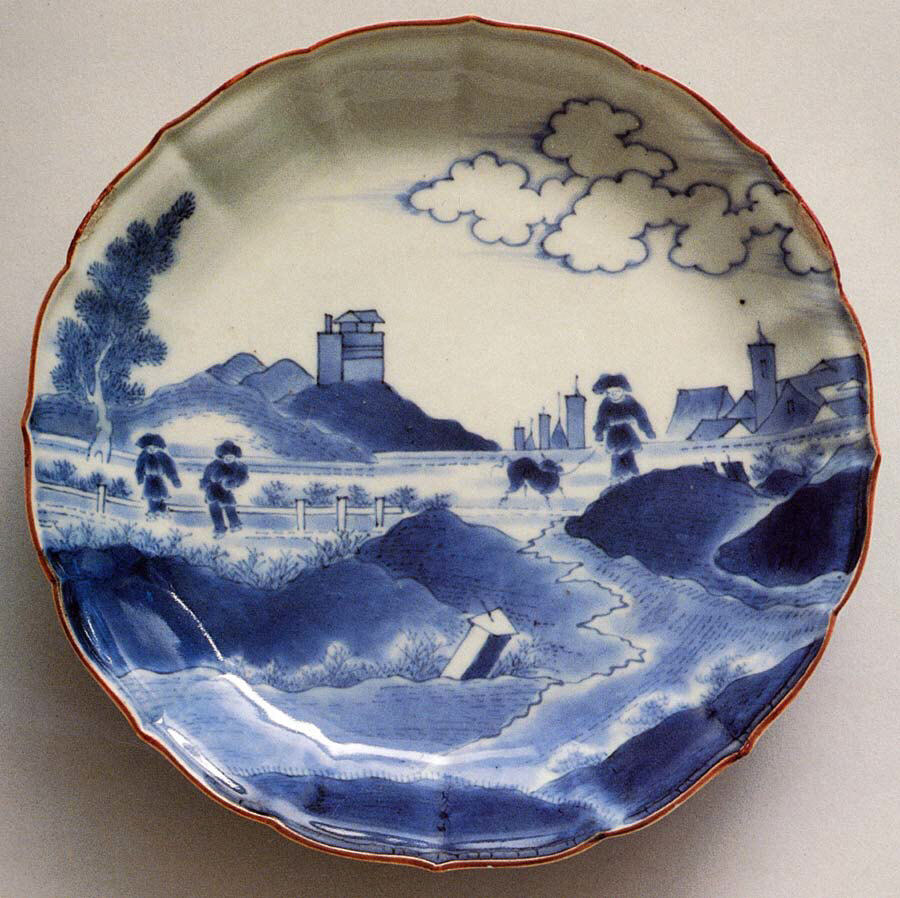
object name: dish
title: Dish with Dutch Landscape (Deshima Island or View of Scheveningen)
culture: japanese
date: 1701-1733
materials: porcelain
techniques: underglaze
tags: human figures,landscapes